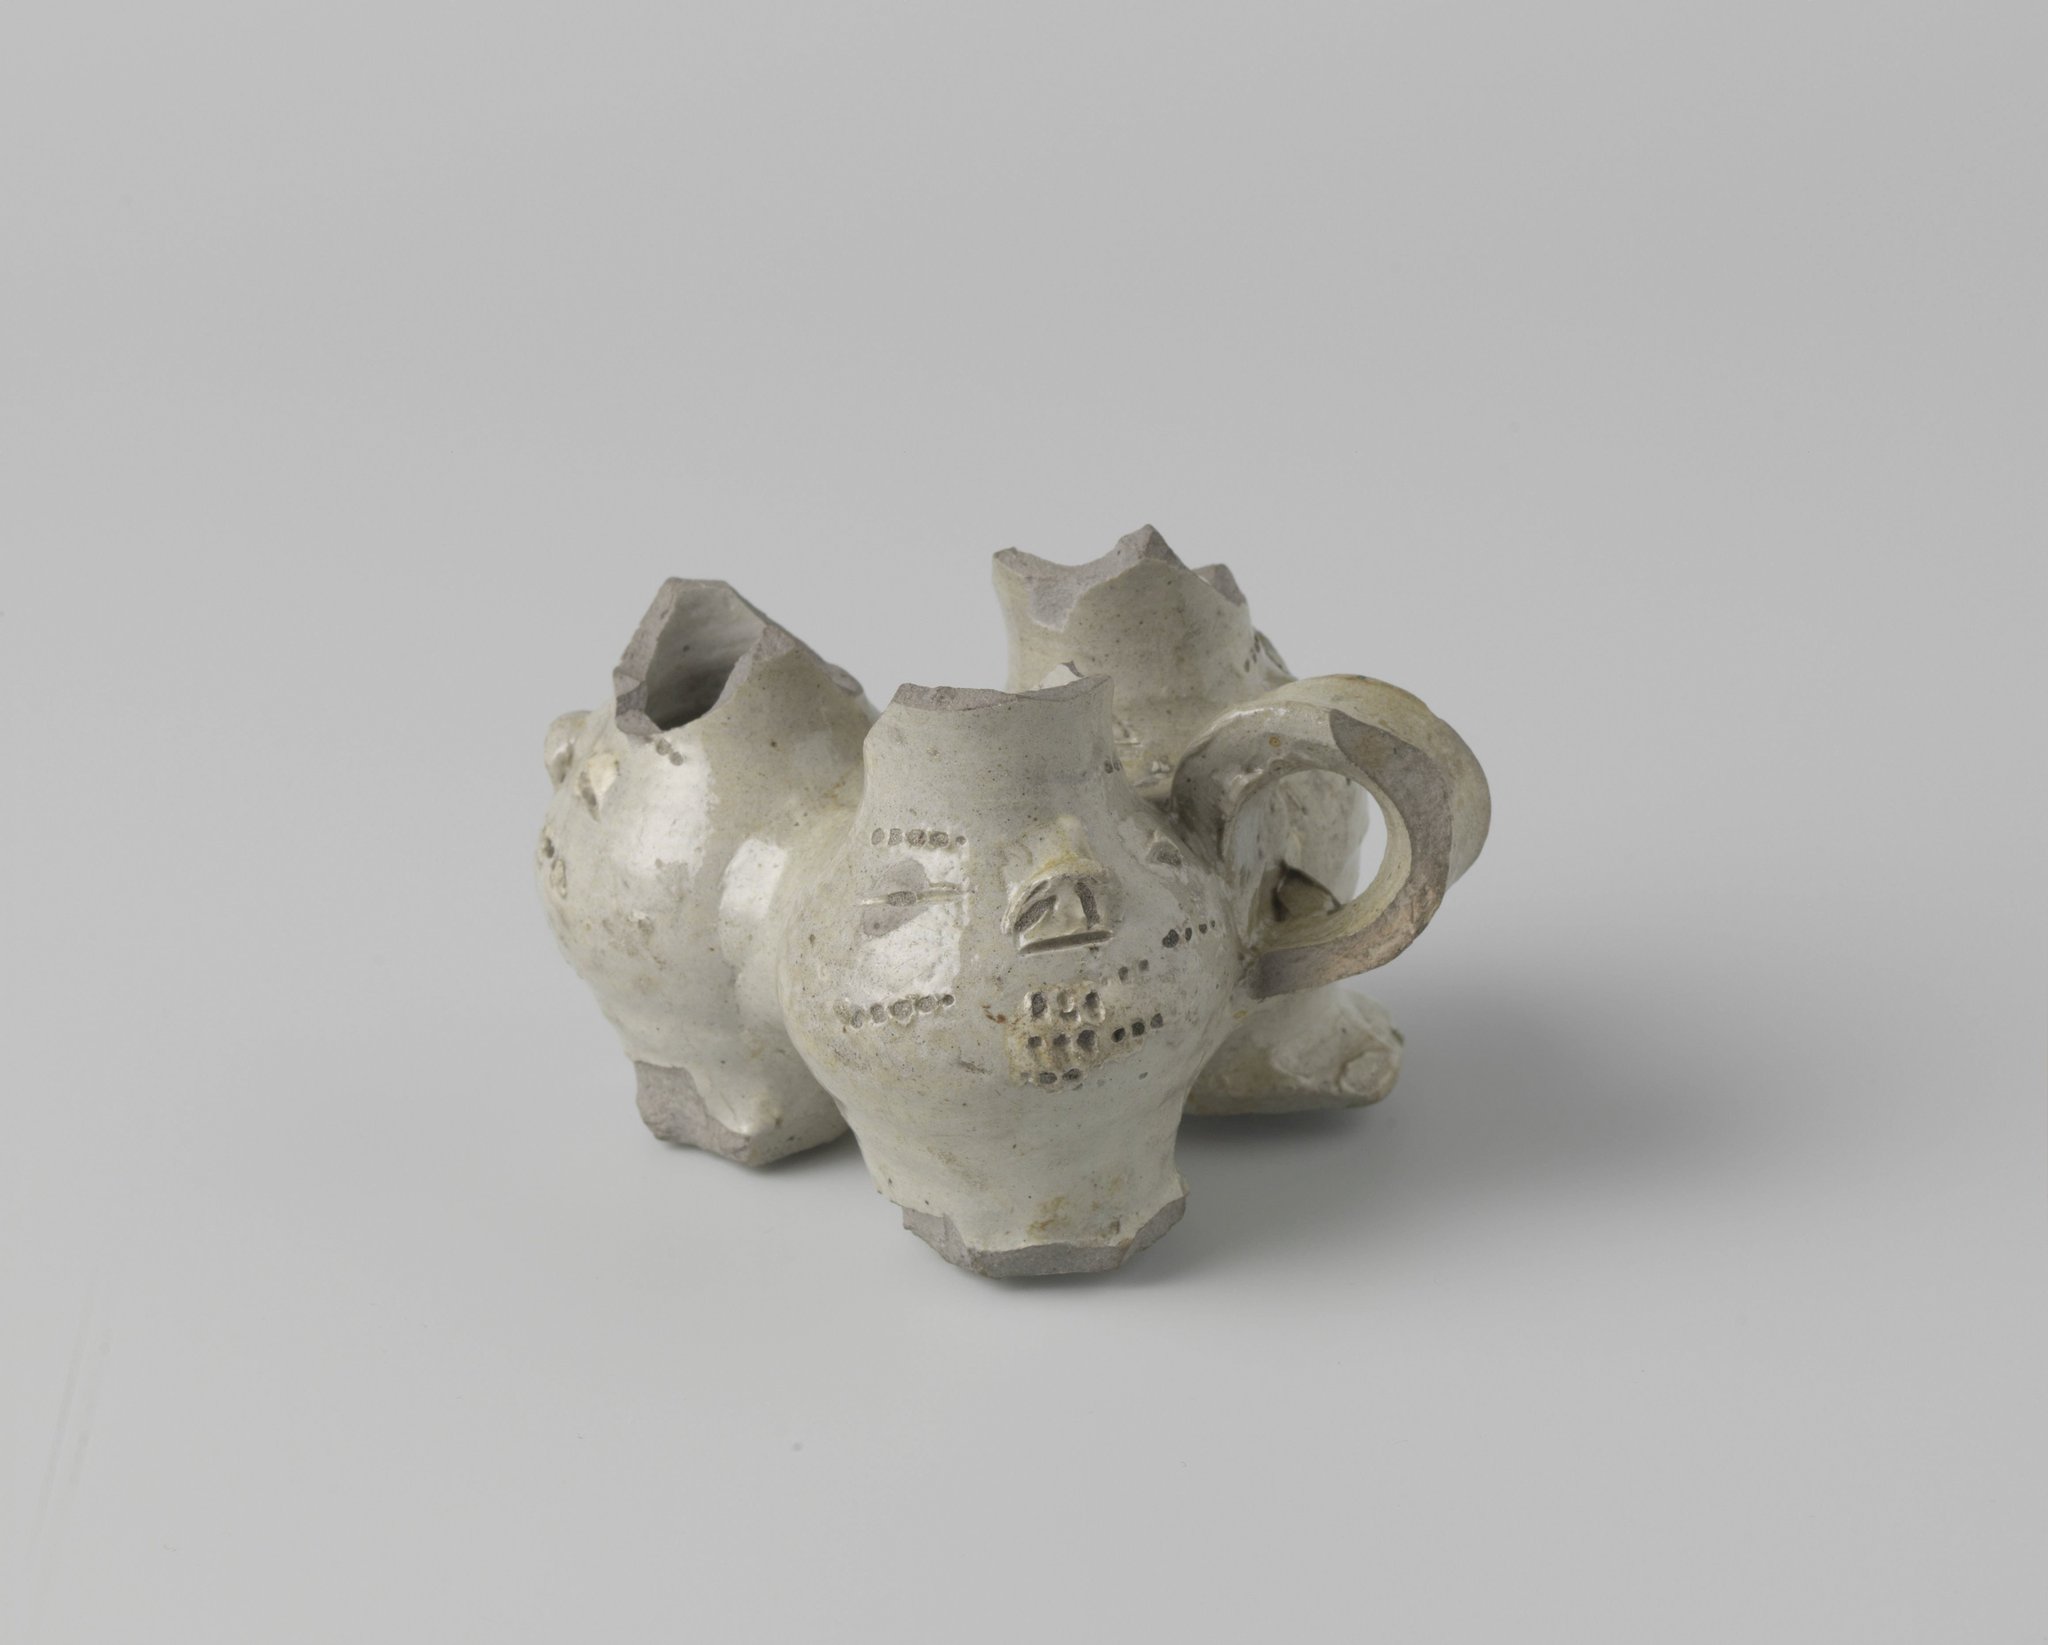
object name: ewer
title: Jug 'driebroederkan'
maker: Anonymous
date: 1500-1520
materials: glaze, stoneware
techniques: firing, forming, relief, turning, vitrification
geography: raeren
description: Zogenaamd driebroederkannetje van steengoed. Bestaande uit drie samengebakken kannetjes. Elk kannetje heeft een eivormige buik en een trechtervormige hals. Op elk kannetje een vrij met de hand gekneed en ingegrift mansgezicht.